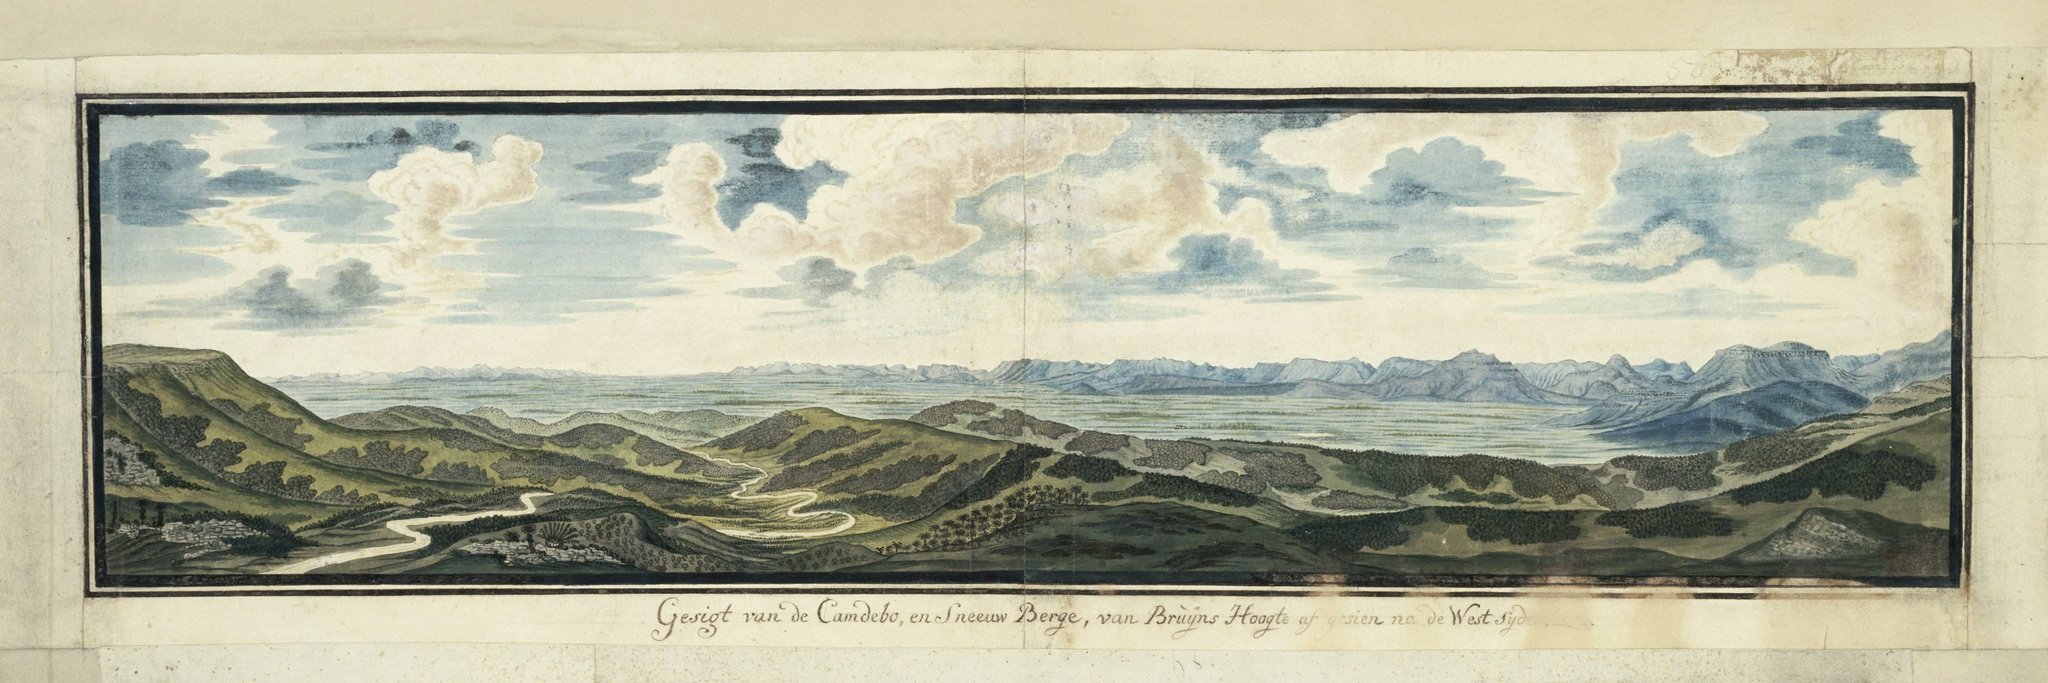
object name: drawing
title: Panorama of Camdbo and the Sneeuberg Mountains, see from Bruintjeshoogte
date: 1711-1777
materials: ink, paper, pencil, watercolor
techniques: brush, pen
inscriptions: annotation: ‘Gesigt van de Camdebo, en Sneeuw Berge, van Bruijns Hoogte af gesien na de West Syde’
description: Oorspronkelijk in omslag van roodkleurig halfleer en roodgemarmerd plat, dorso met ribben en goudopdruk; 71 x 99 x 6 cm.